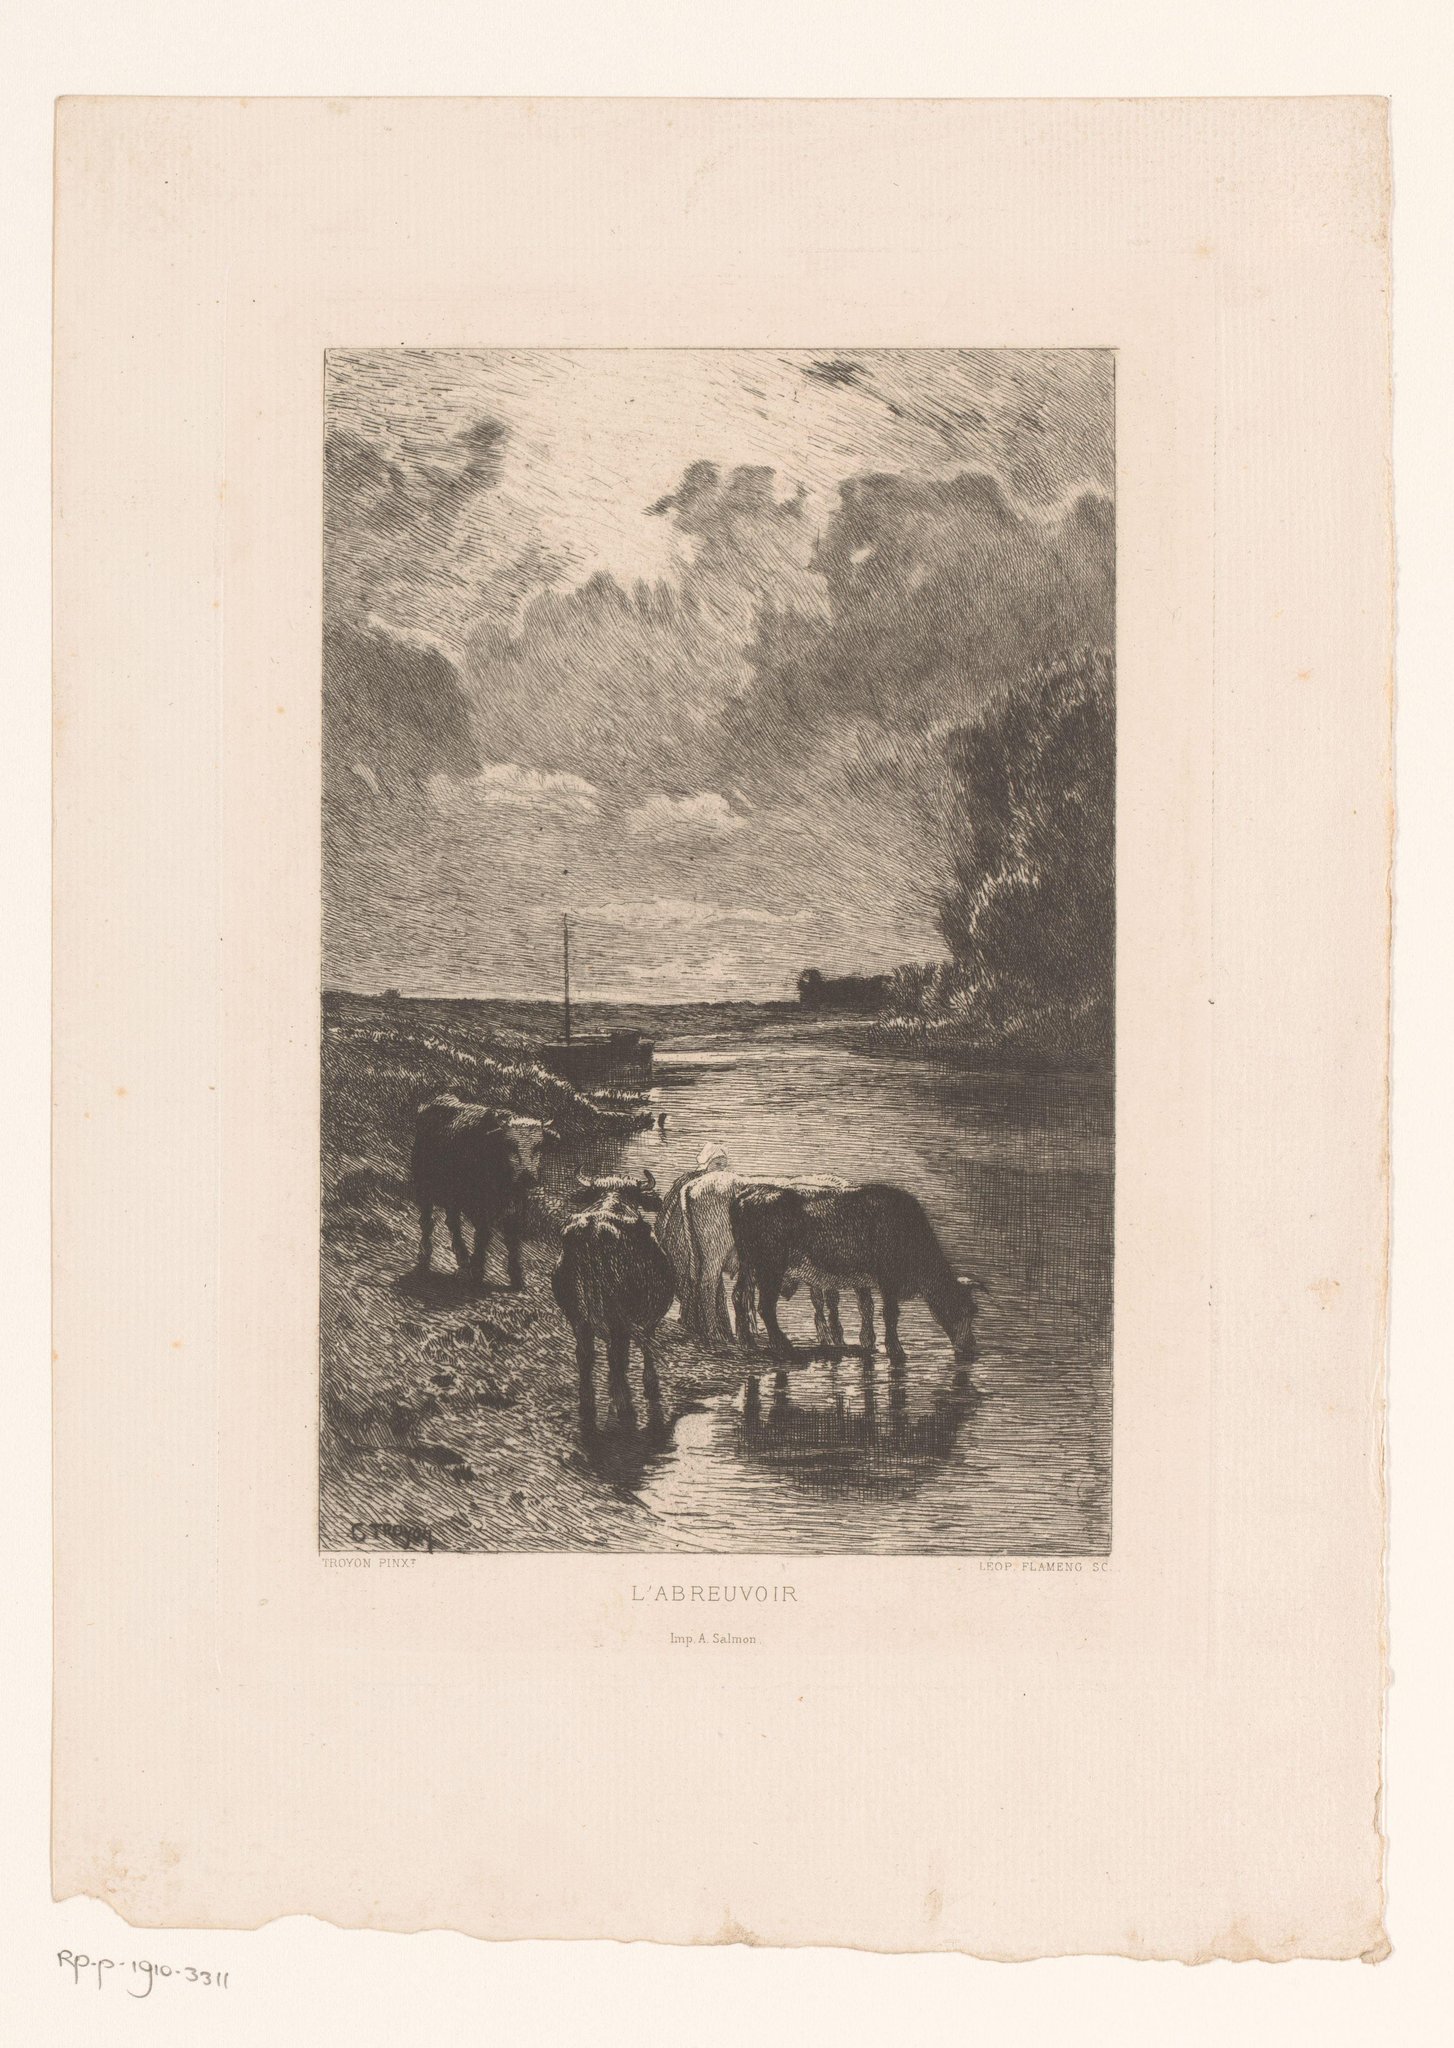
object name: print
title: Koeien bij een drinkplaats aan de oever van een rivier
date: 1874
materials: paper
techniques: etching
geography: paris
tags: cow, river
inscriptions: collector's mark: Lugt 2228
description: Een andere staat van deze prent is gebruikt in: Gazette des beaux-arts (1874), 1 juni 1874, p. 534-535.